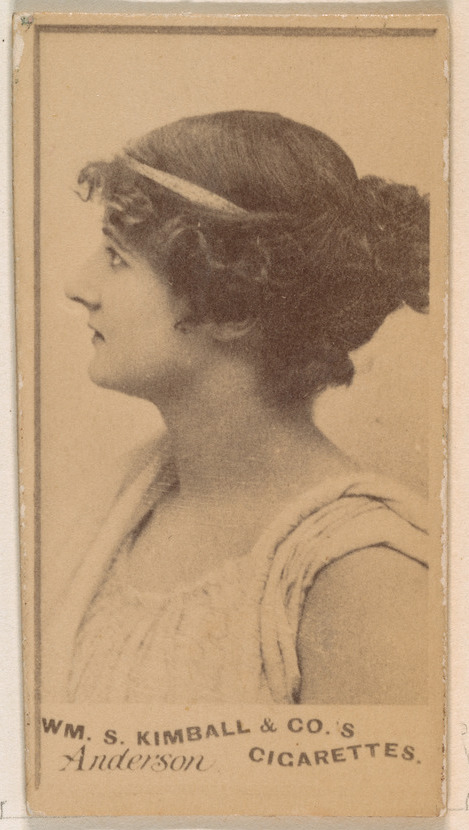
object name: photograph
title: Miss Anderson, from the Actresses series (N203) issued by Wm. S. Kimball & Co.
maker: william s. kimball & company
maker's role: publisher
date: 1889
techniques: color lithograph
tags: portraits,women,actresses